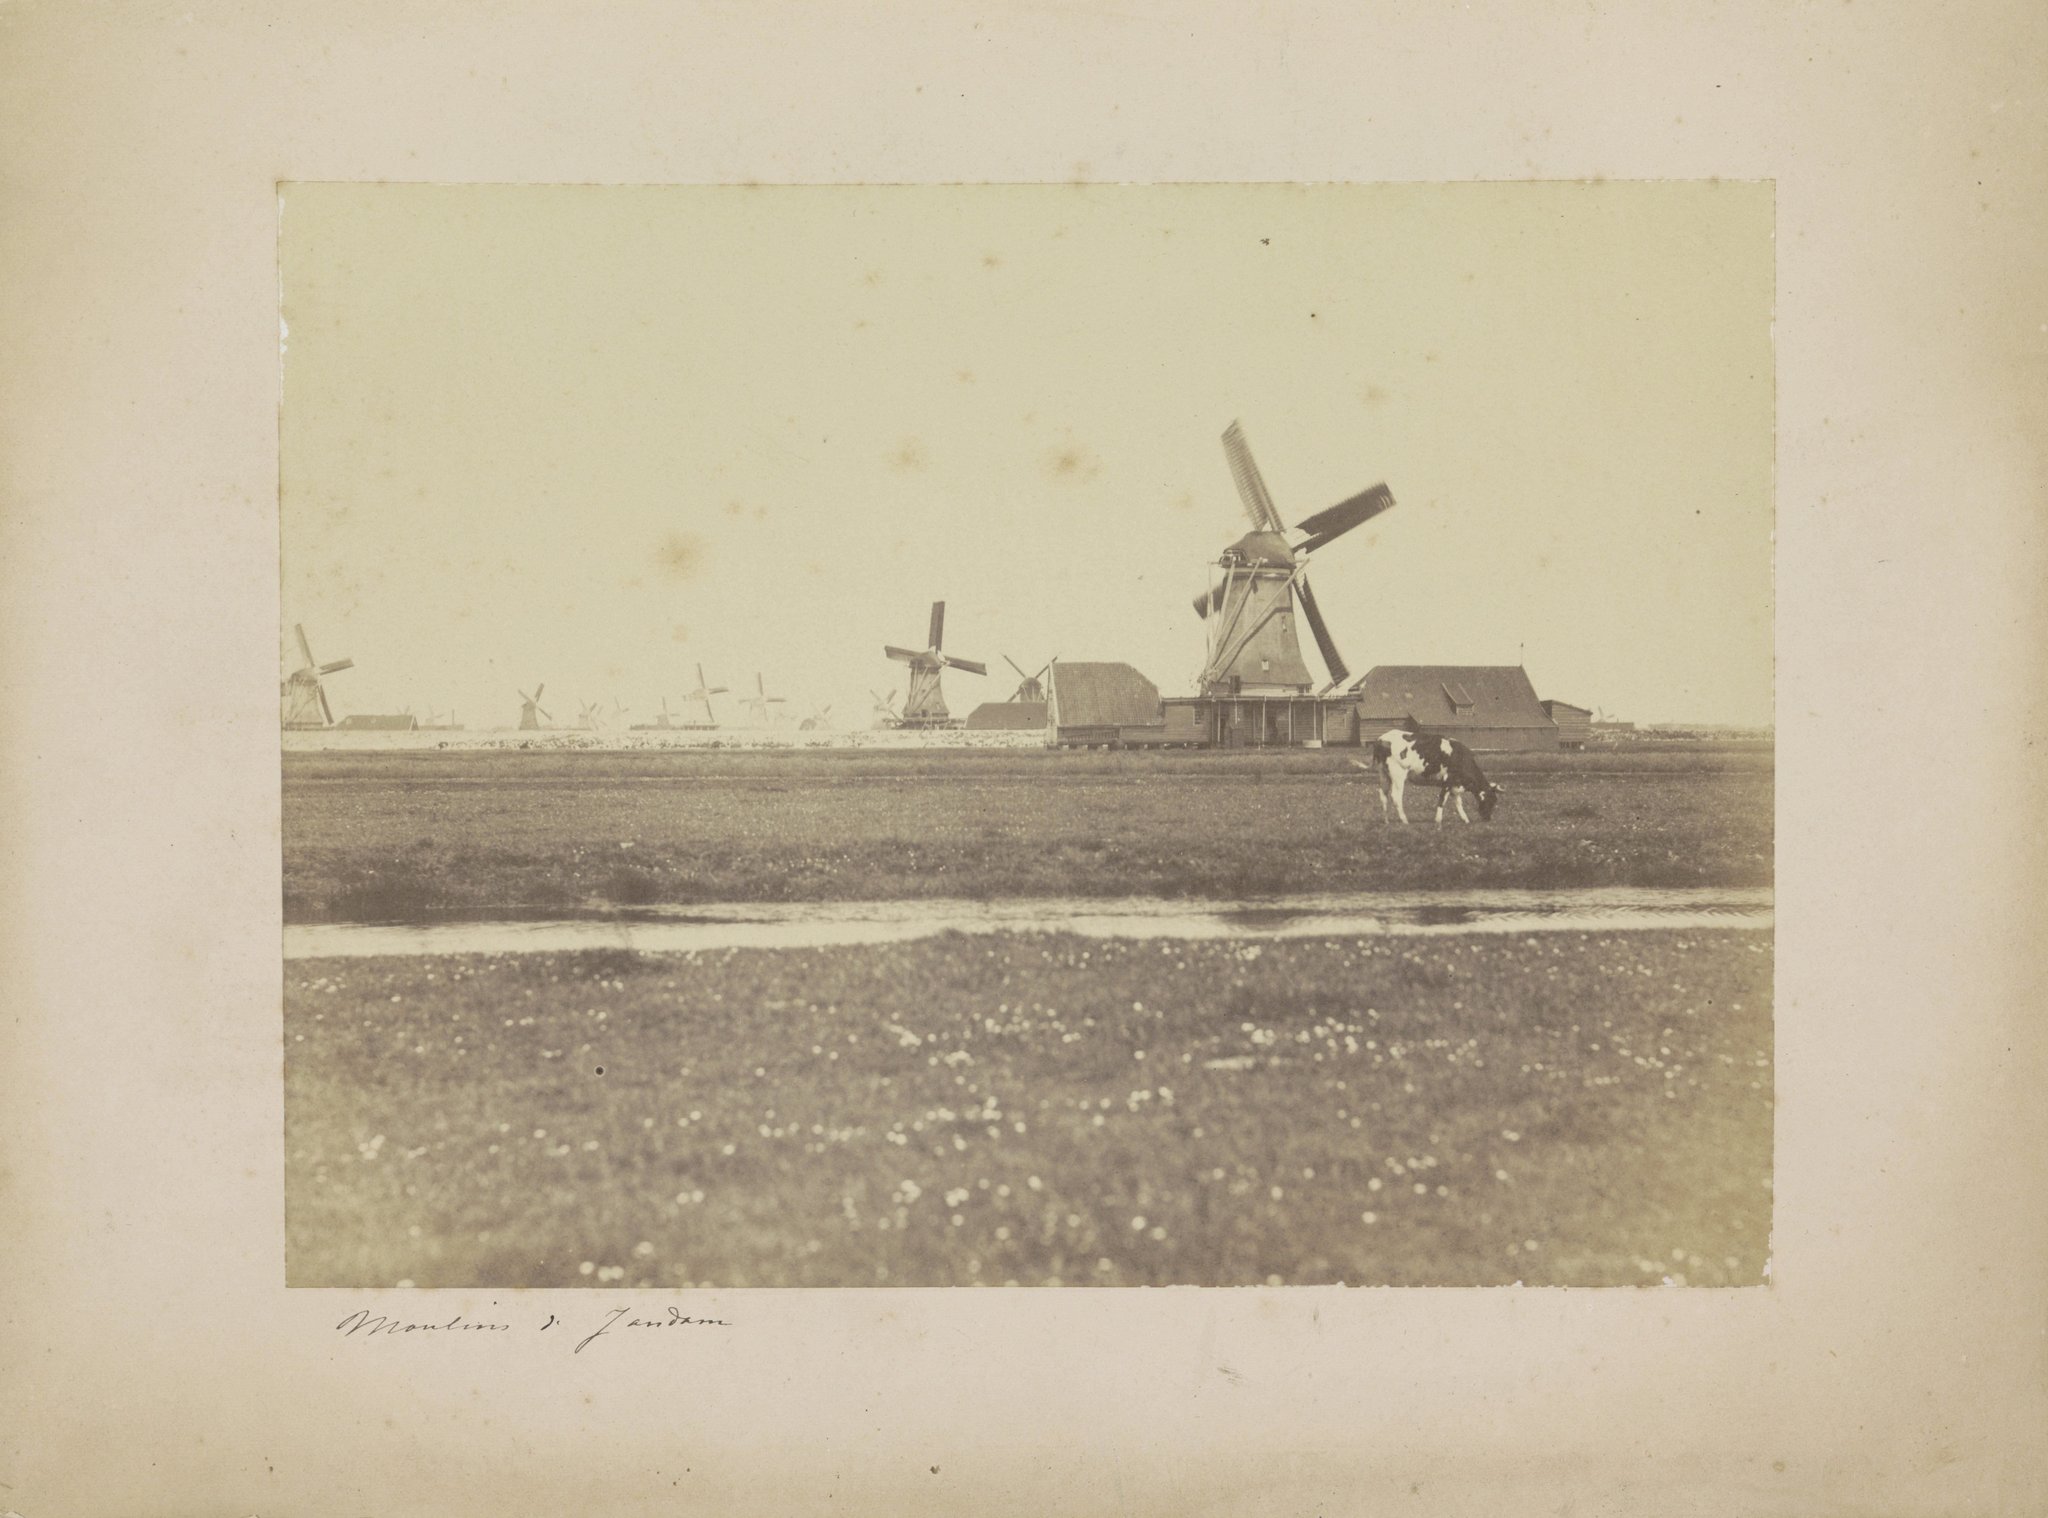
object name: photograph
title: Landschap met molens in Zaandam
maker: Anonymous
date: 1885-1900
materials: paper, photographic support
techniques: albumen print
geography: zaandam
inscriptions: annotation: ‘Moulins de Za[a]ndam’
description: Landschap met molens, Zaandam, Nederland. Op de voorgrond een koe in het weiland.